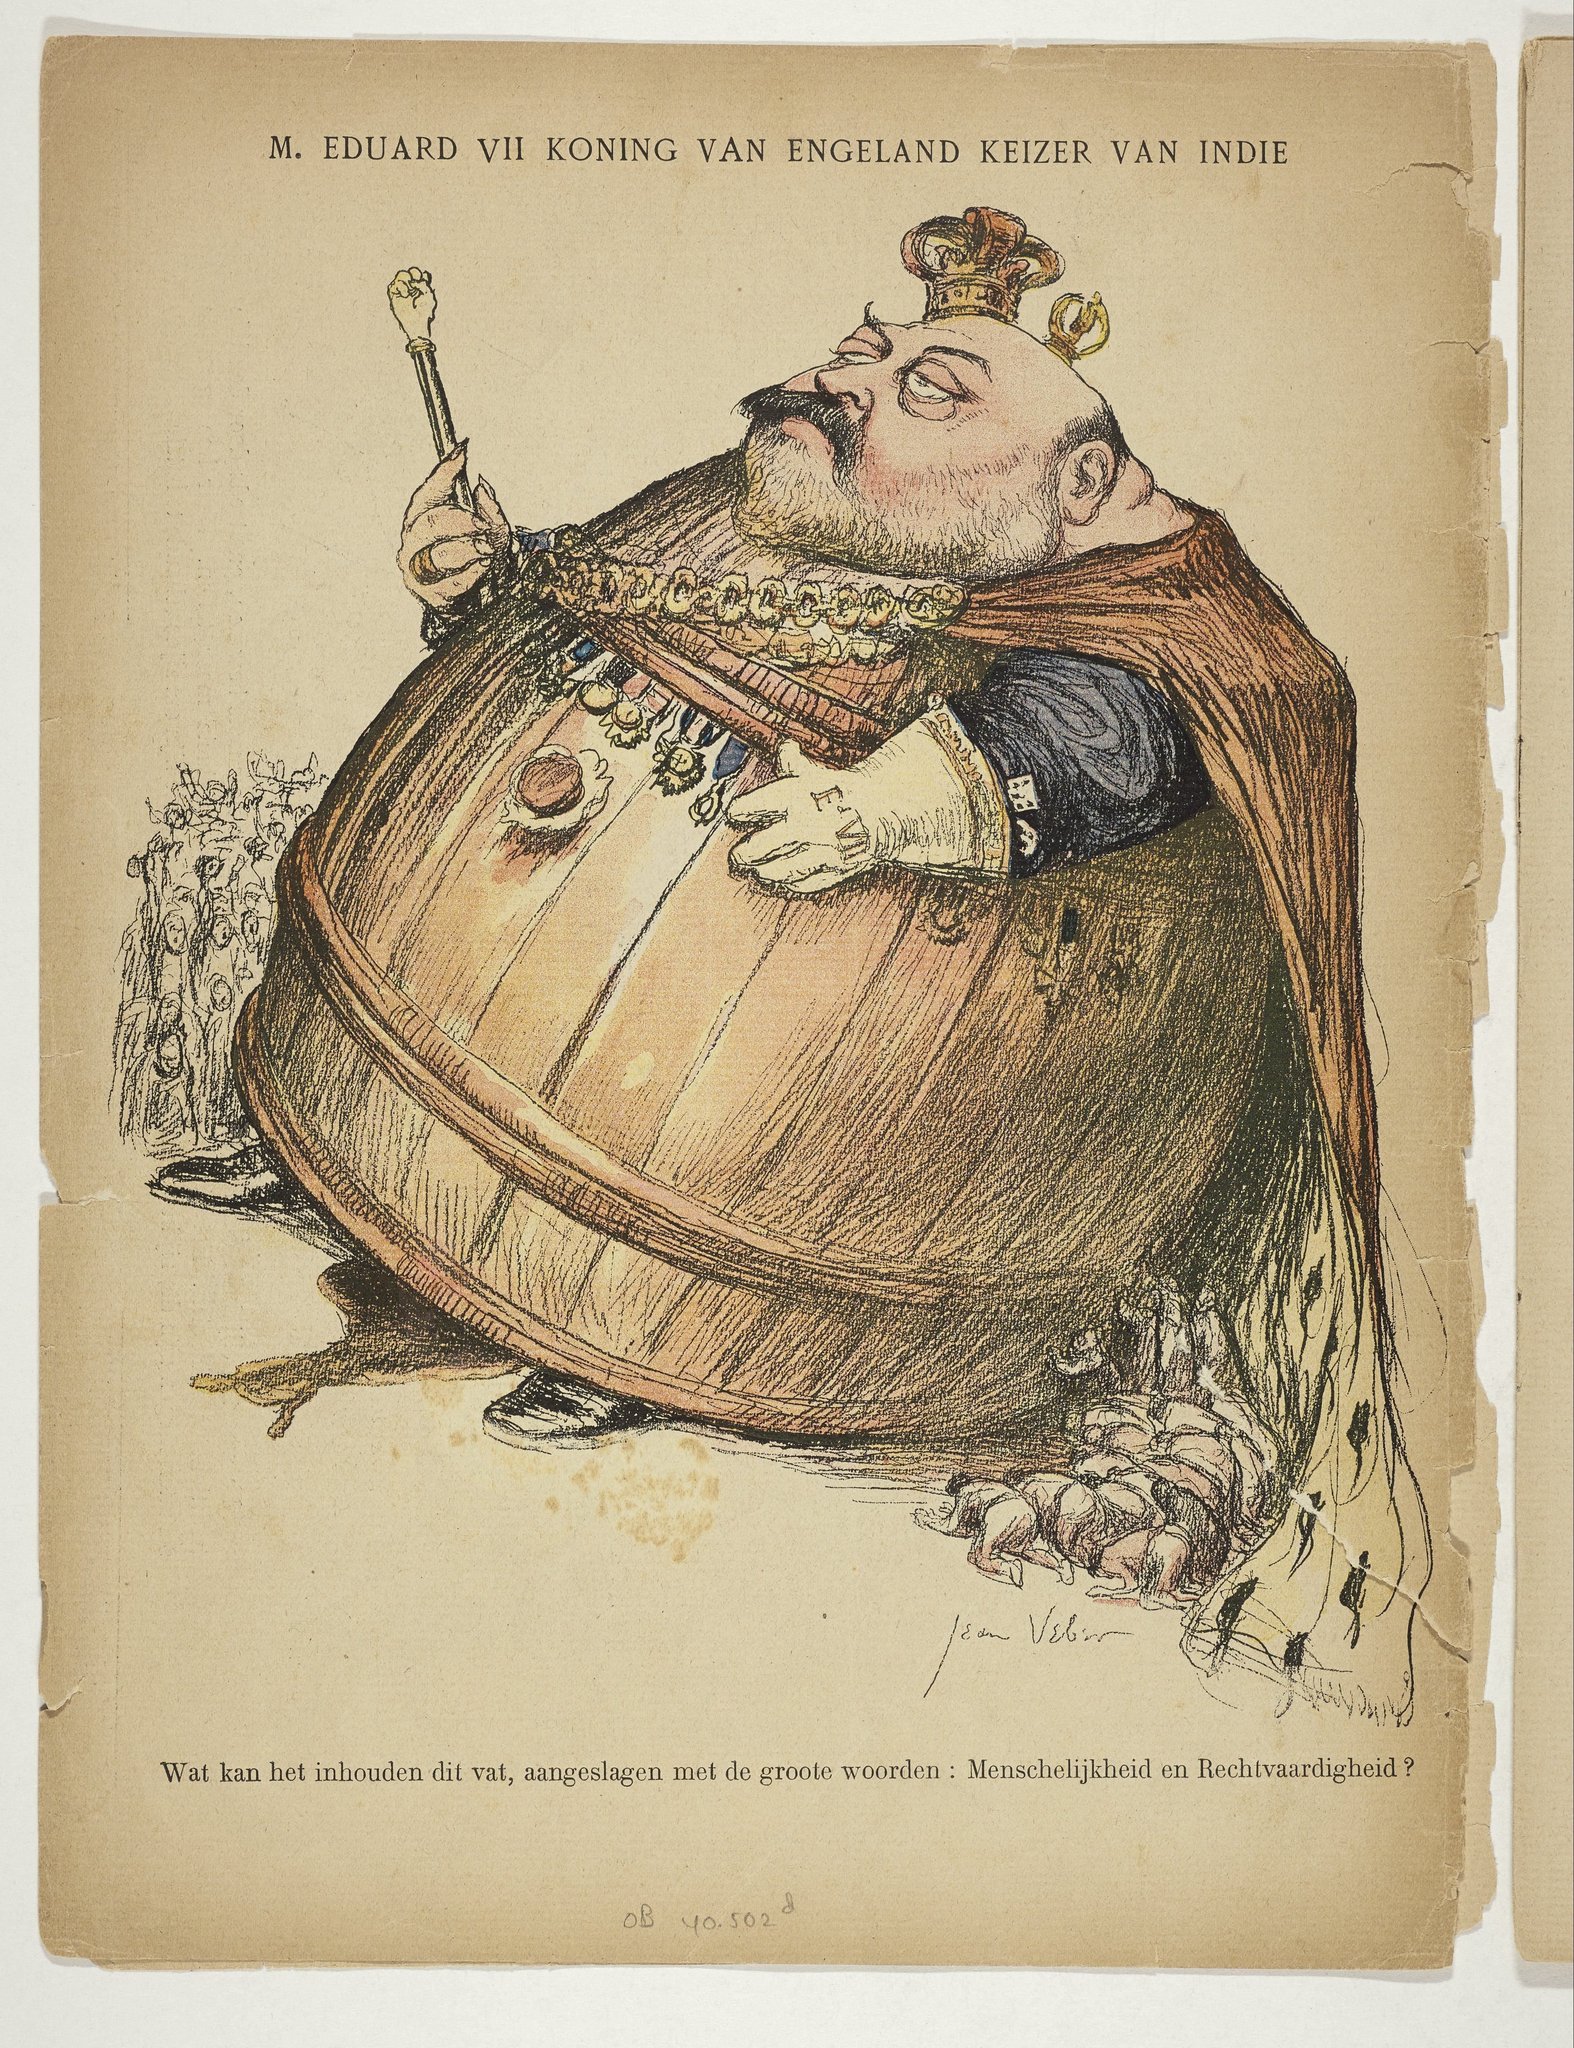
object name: page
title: Karikatuur van Eduard VII (koning van het Verenigd Koninkrijk)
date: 1901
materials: paper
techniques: lithograph, letterpress printing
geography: amsterdam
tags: london, political caricatures and satires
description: Prent uit: De Boeren-Kampen / (Les camps de reconcentration), 1901. Dit is de geautoriseerde Nederlandse uitgave van: L'Assiette au Beurre 1 (1901), nr. 26 (Les camps de reconcentration au Transvaal), 28 september 1901.